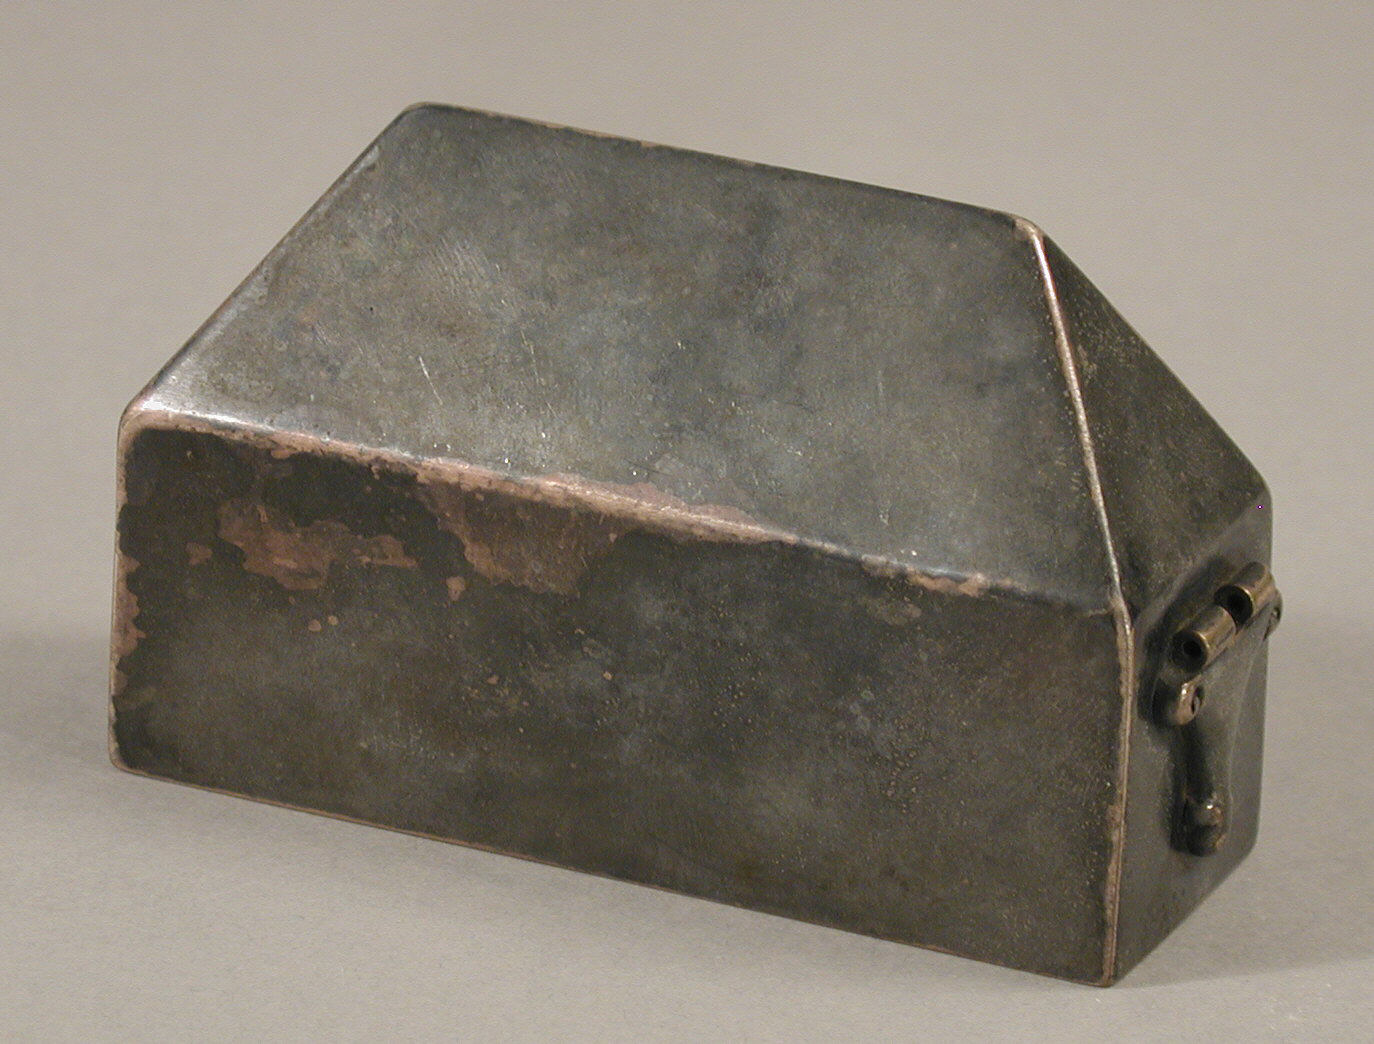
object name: shrine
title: Lough Erne Shrine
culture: irish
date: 1901-1933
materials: bronze, gilt